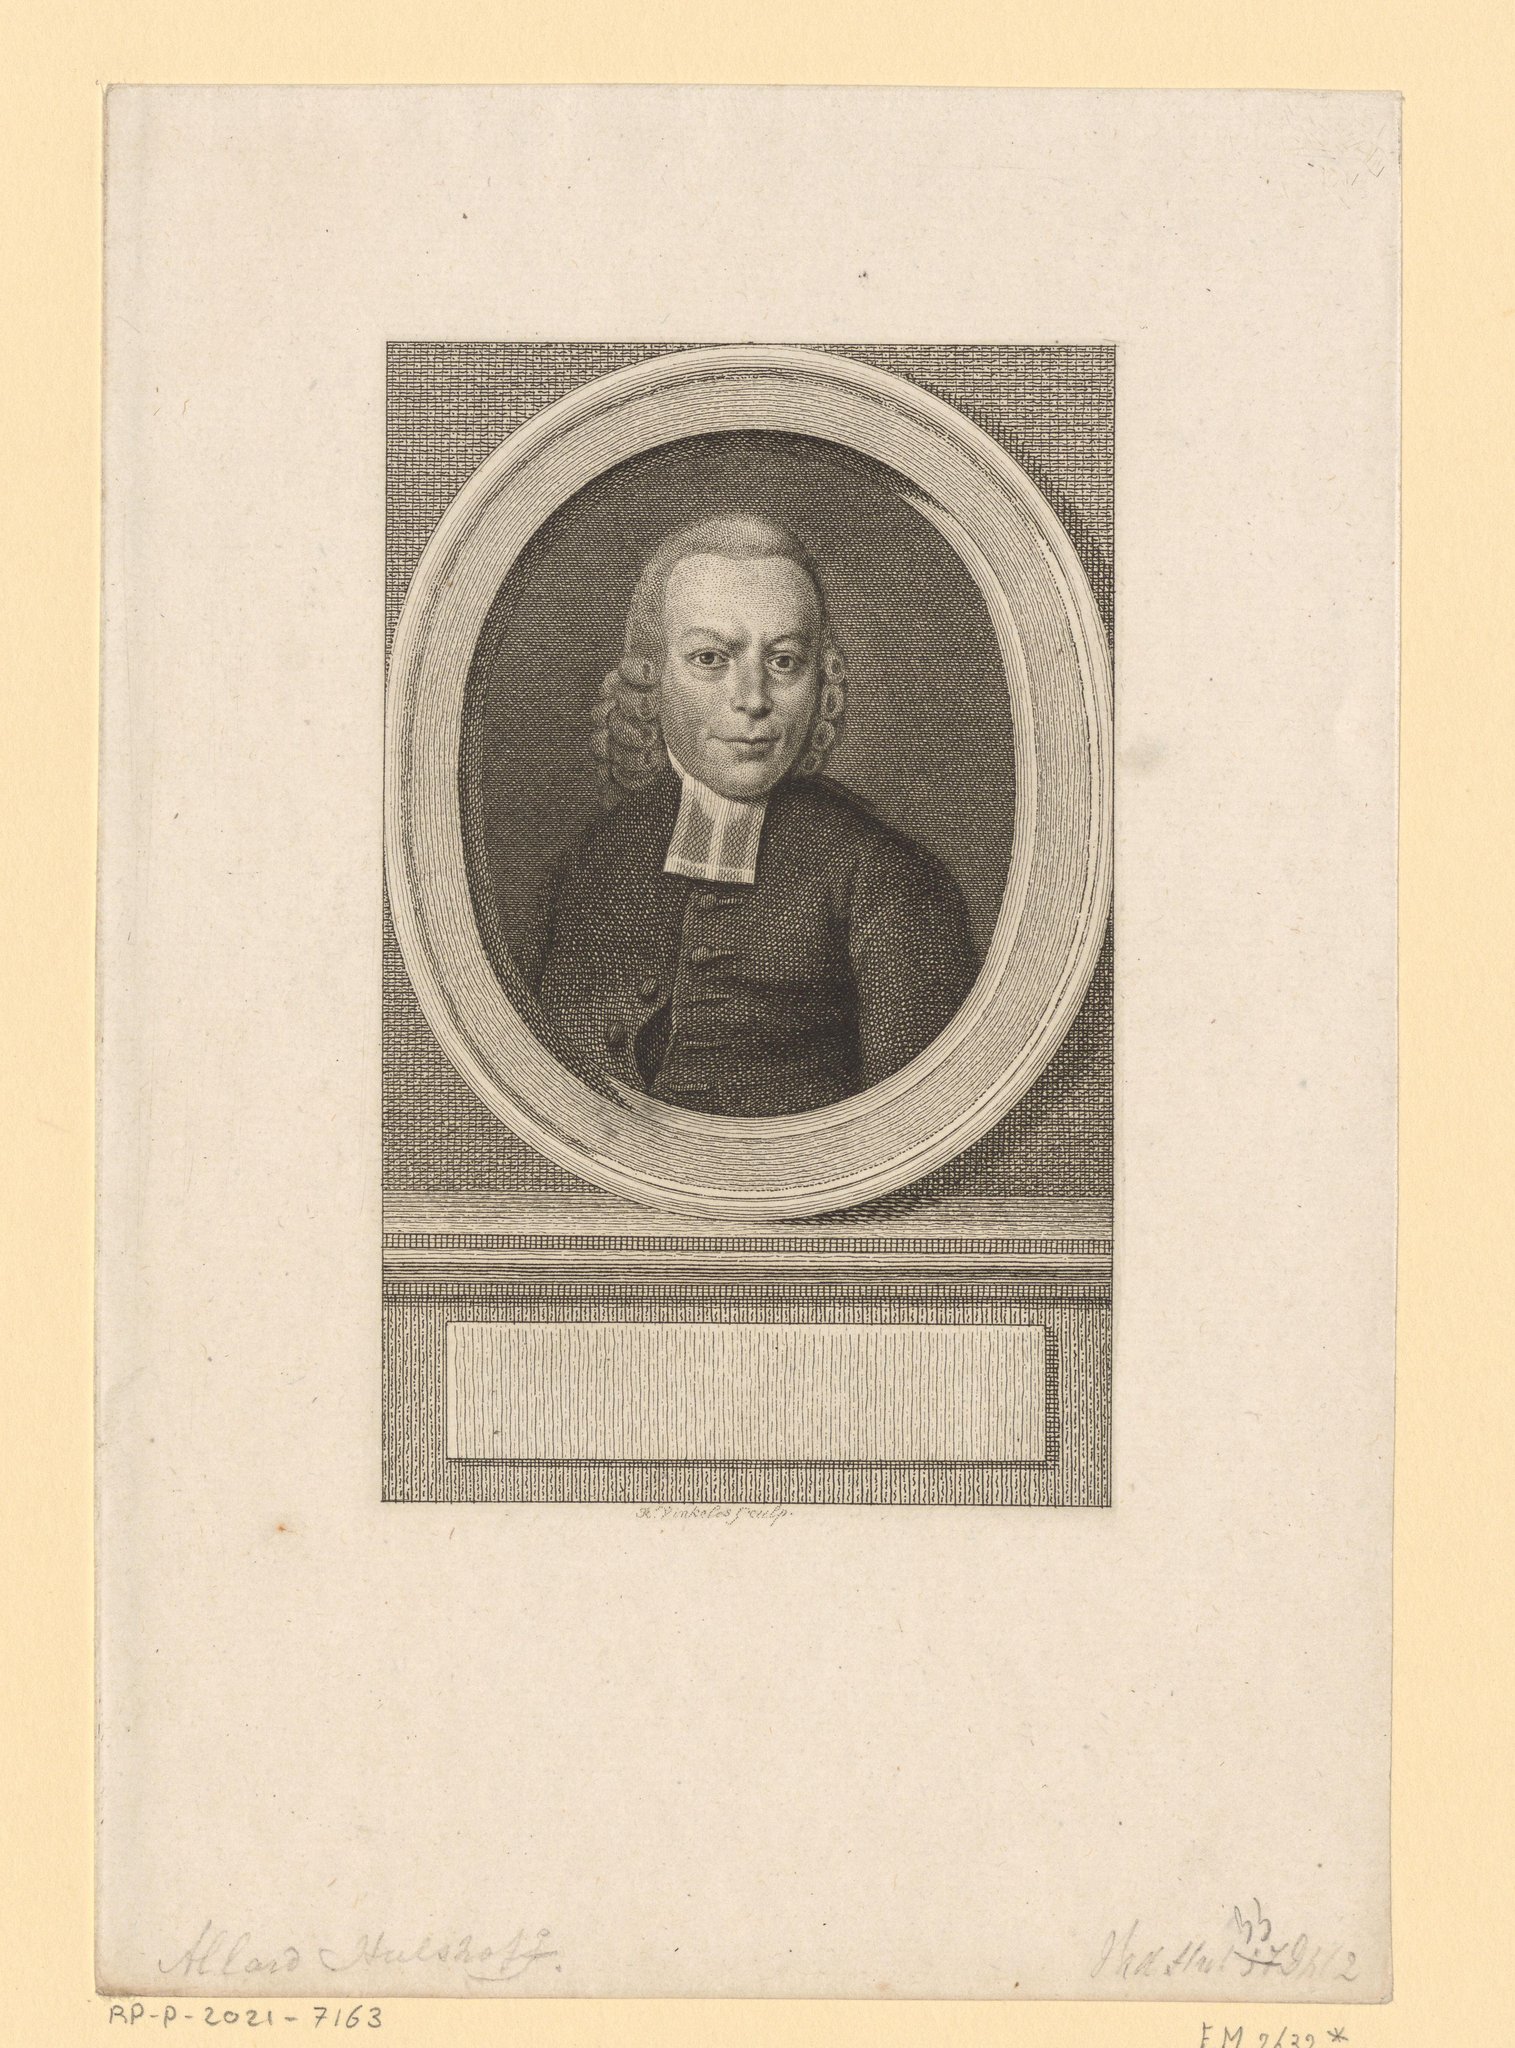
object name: print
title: Portret van Allard Hulshoff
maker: reinier vinkeles (i)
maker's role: draughtsman, print maker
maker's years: 1741-1816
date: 1786-1811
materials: paper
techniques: engraving, etching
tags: amsterdam, historical persons, functionaries and dignitaries ~ episcopal protestant churches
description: Latere staat van de prent gebruikt in: Loosjes, Petrus. Vaderlandsche historie, (...) ten vervolge van Wagenaars Vaderlandsche historie. Amsterdam: Johannes Allart, 1786-1811, dl. 33.